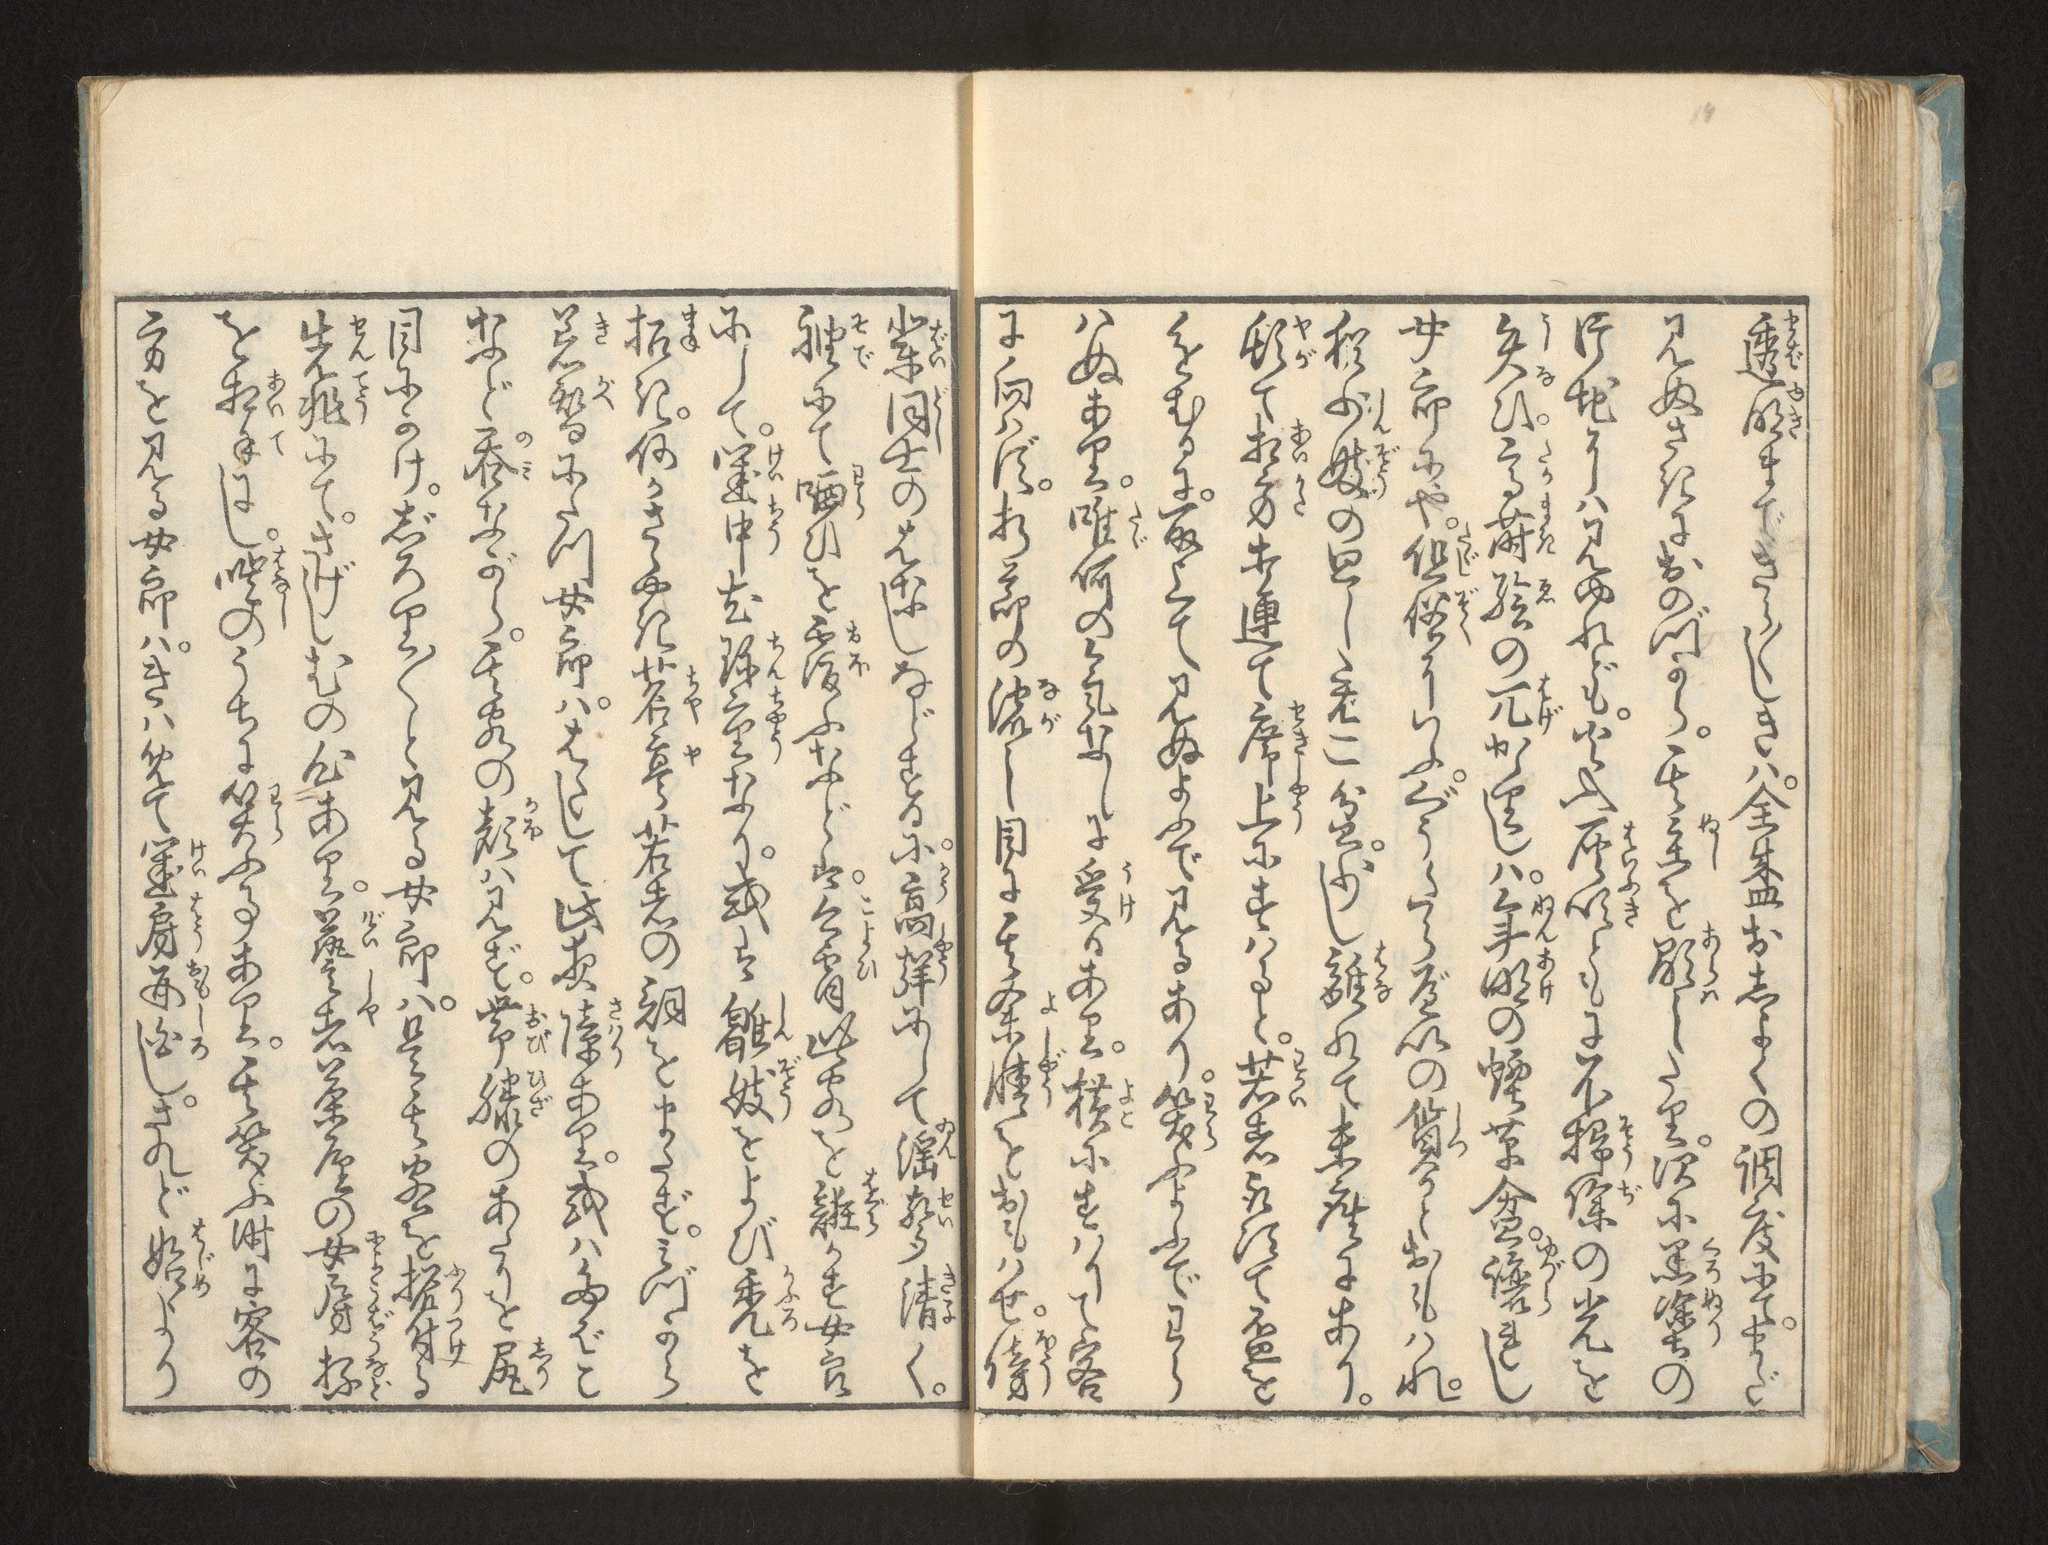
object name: page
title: Tekst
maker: kitagawa utamaro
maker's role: print maker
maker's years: 1753-1806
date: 1804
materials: paper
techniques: woodcut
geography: edo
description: Zevende en achtste tekstpagina van deel twee van Utamaro`s boek: Gebeurtenissen in de lusthuizen gedurende het jaar.